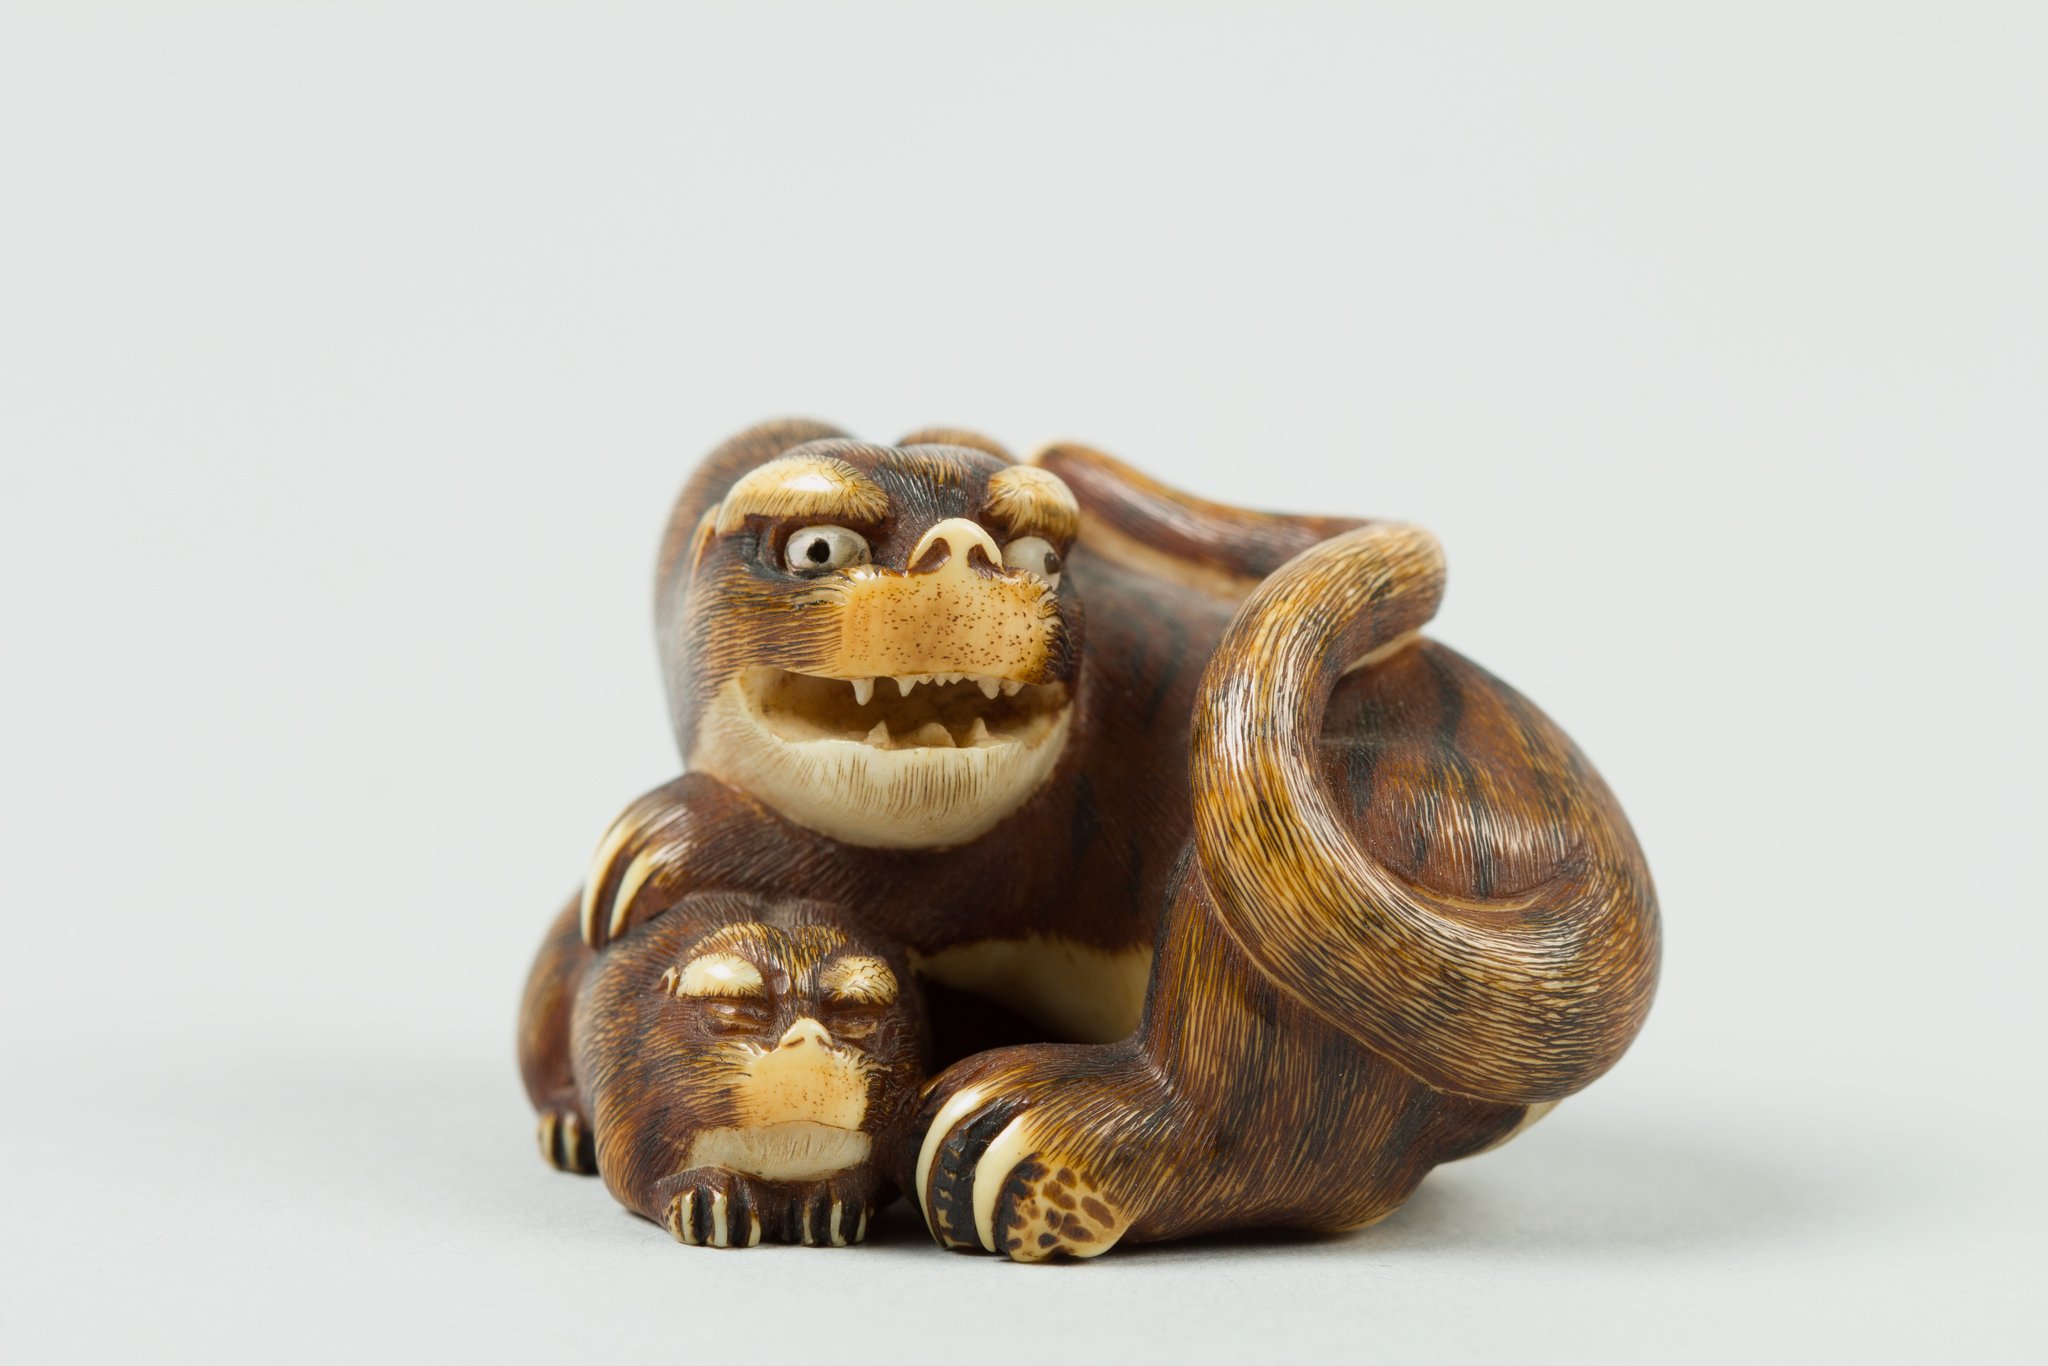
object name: netsuke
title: Netsuke of Tiger and Cub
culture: japanese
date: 1801-1900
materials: ivory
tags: tigers